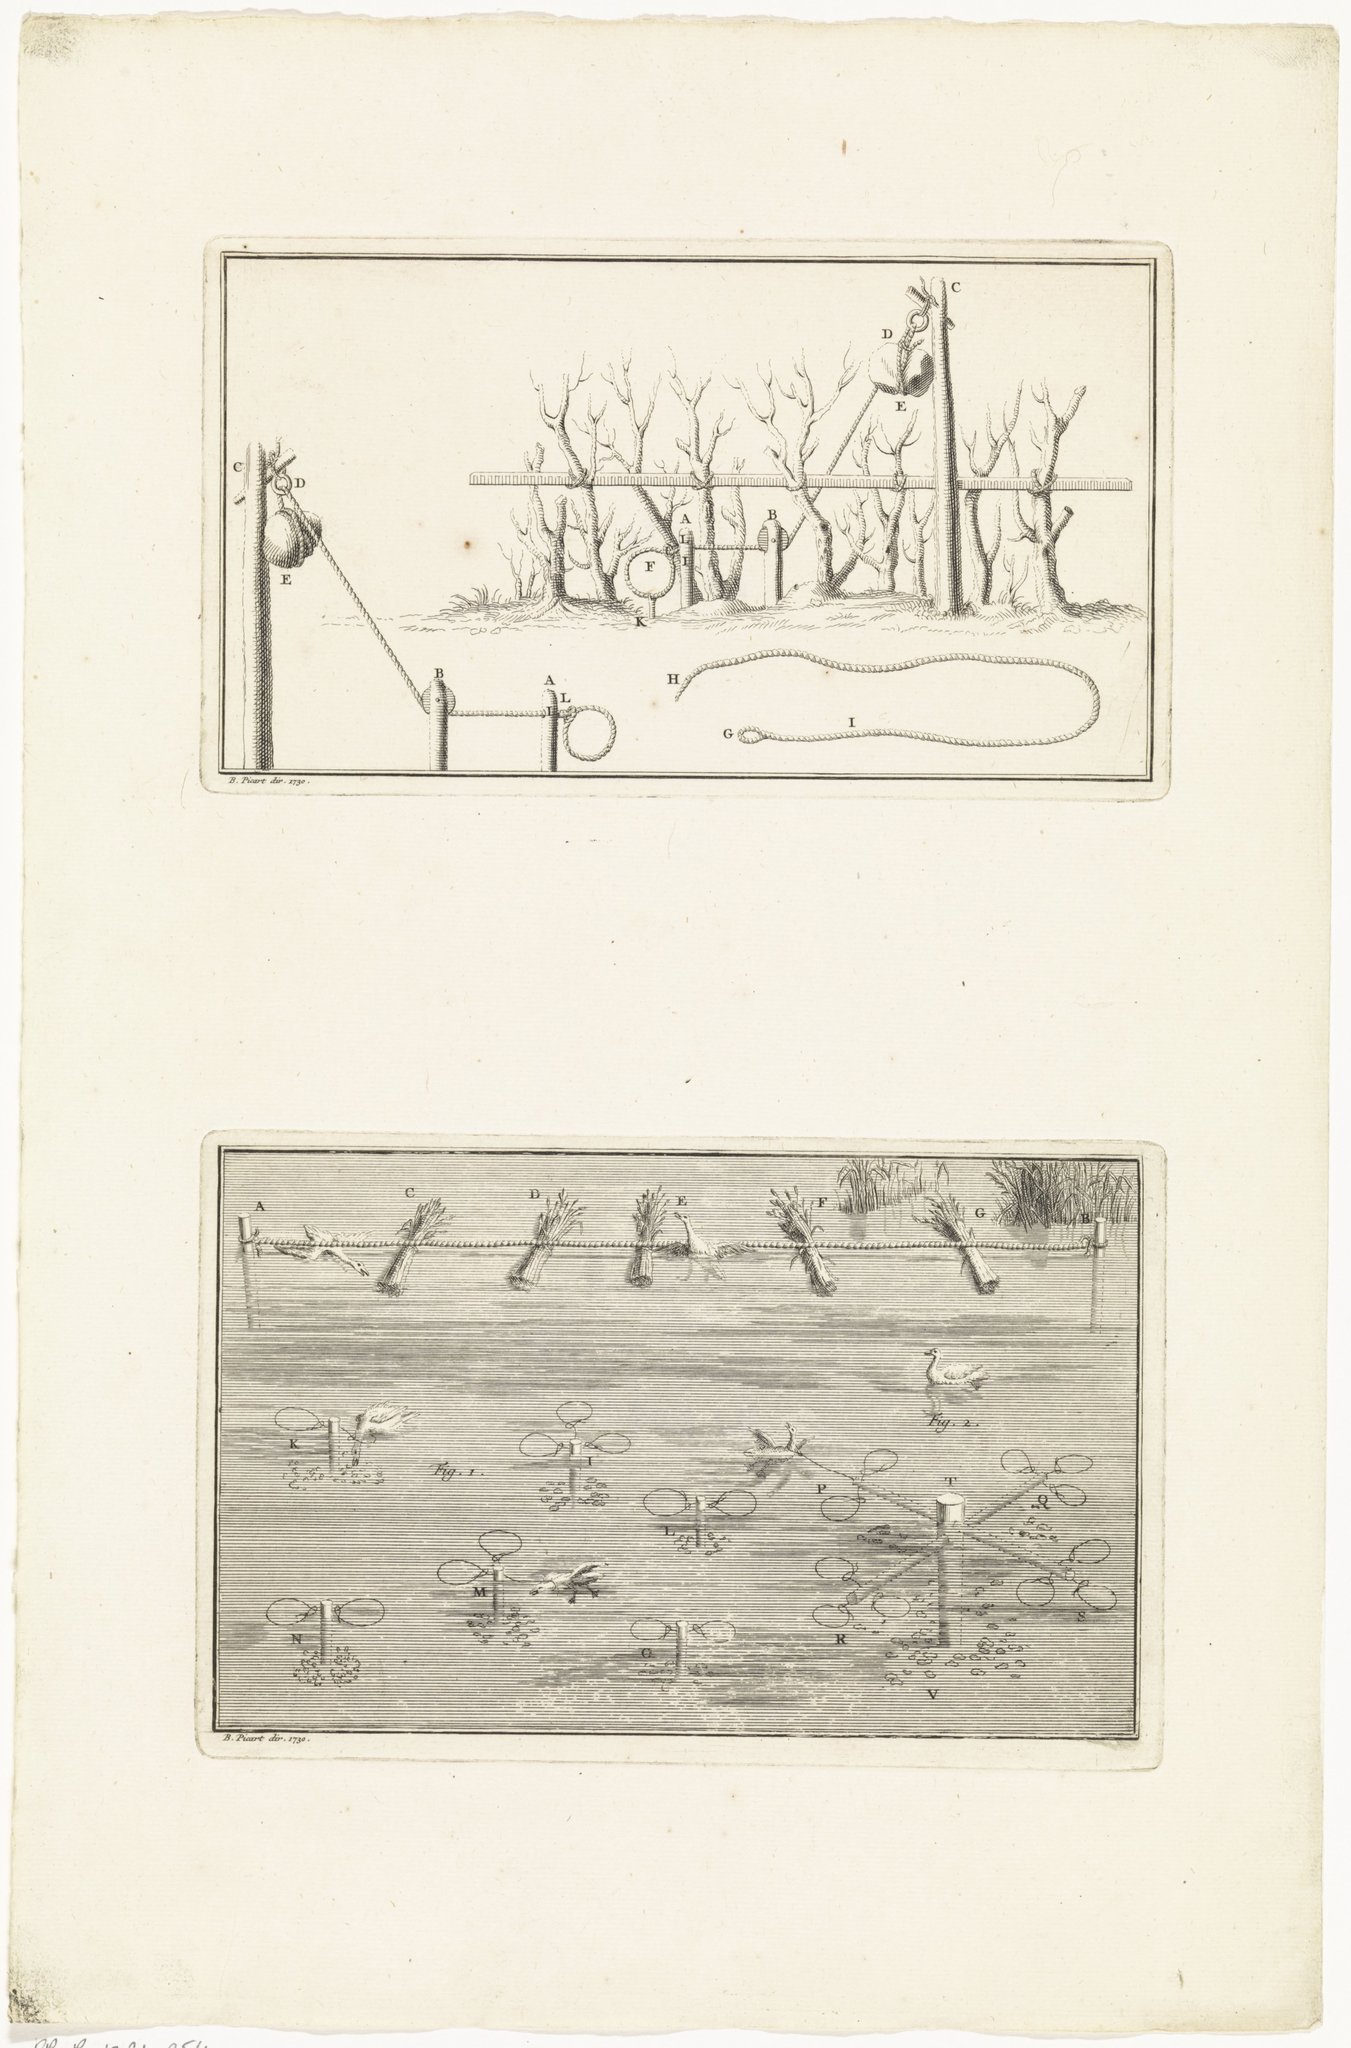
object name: print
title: Constructies voor vogel- en eendenstrikken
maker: bernard picart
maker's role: draughtsman, print maker, publisher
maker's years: 1673-1733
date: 1730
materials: paper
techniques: etching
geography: amsterdam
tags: bird hunting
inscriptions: collector's mark: Lugt 2233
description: Prenten bedoeld voor: Chomel, Noel. Dictionnaire oeconomique, contenant divers moïens d'augmenter son bien, et de conserver sa santé. Amsterdam: Johannes Covens en Cornelis Mortier, 1732.